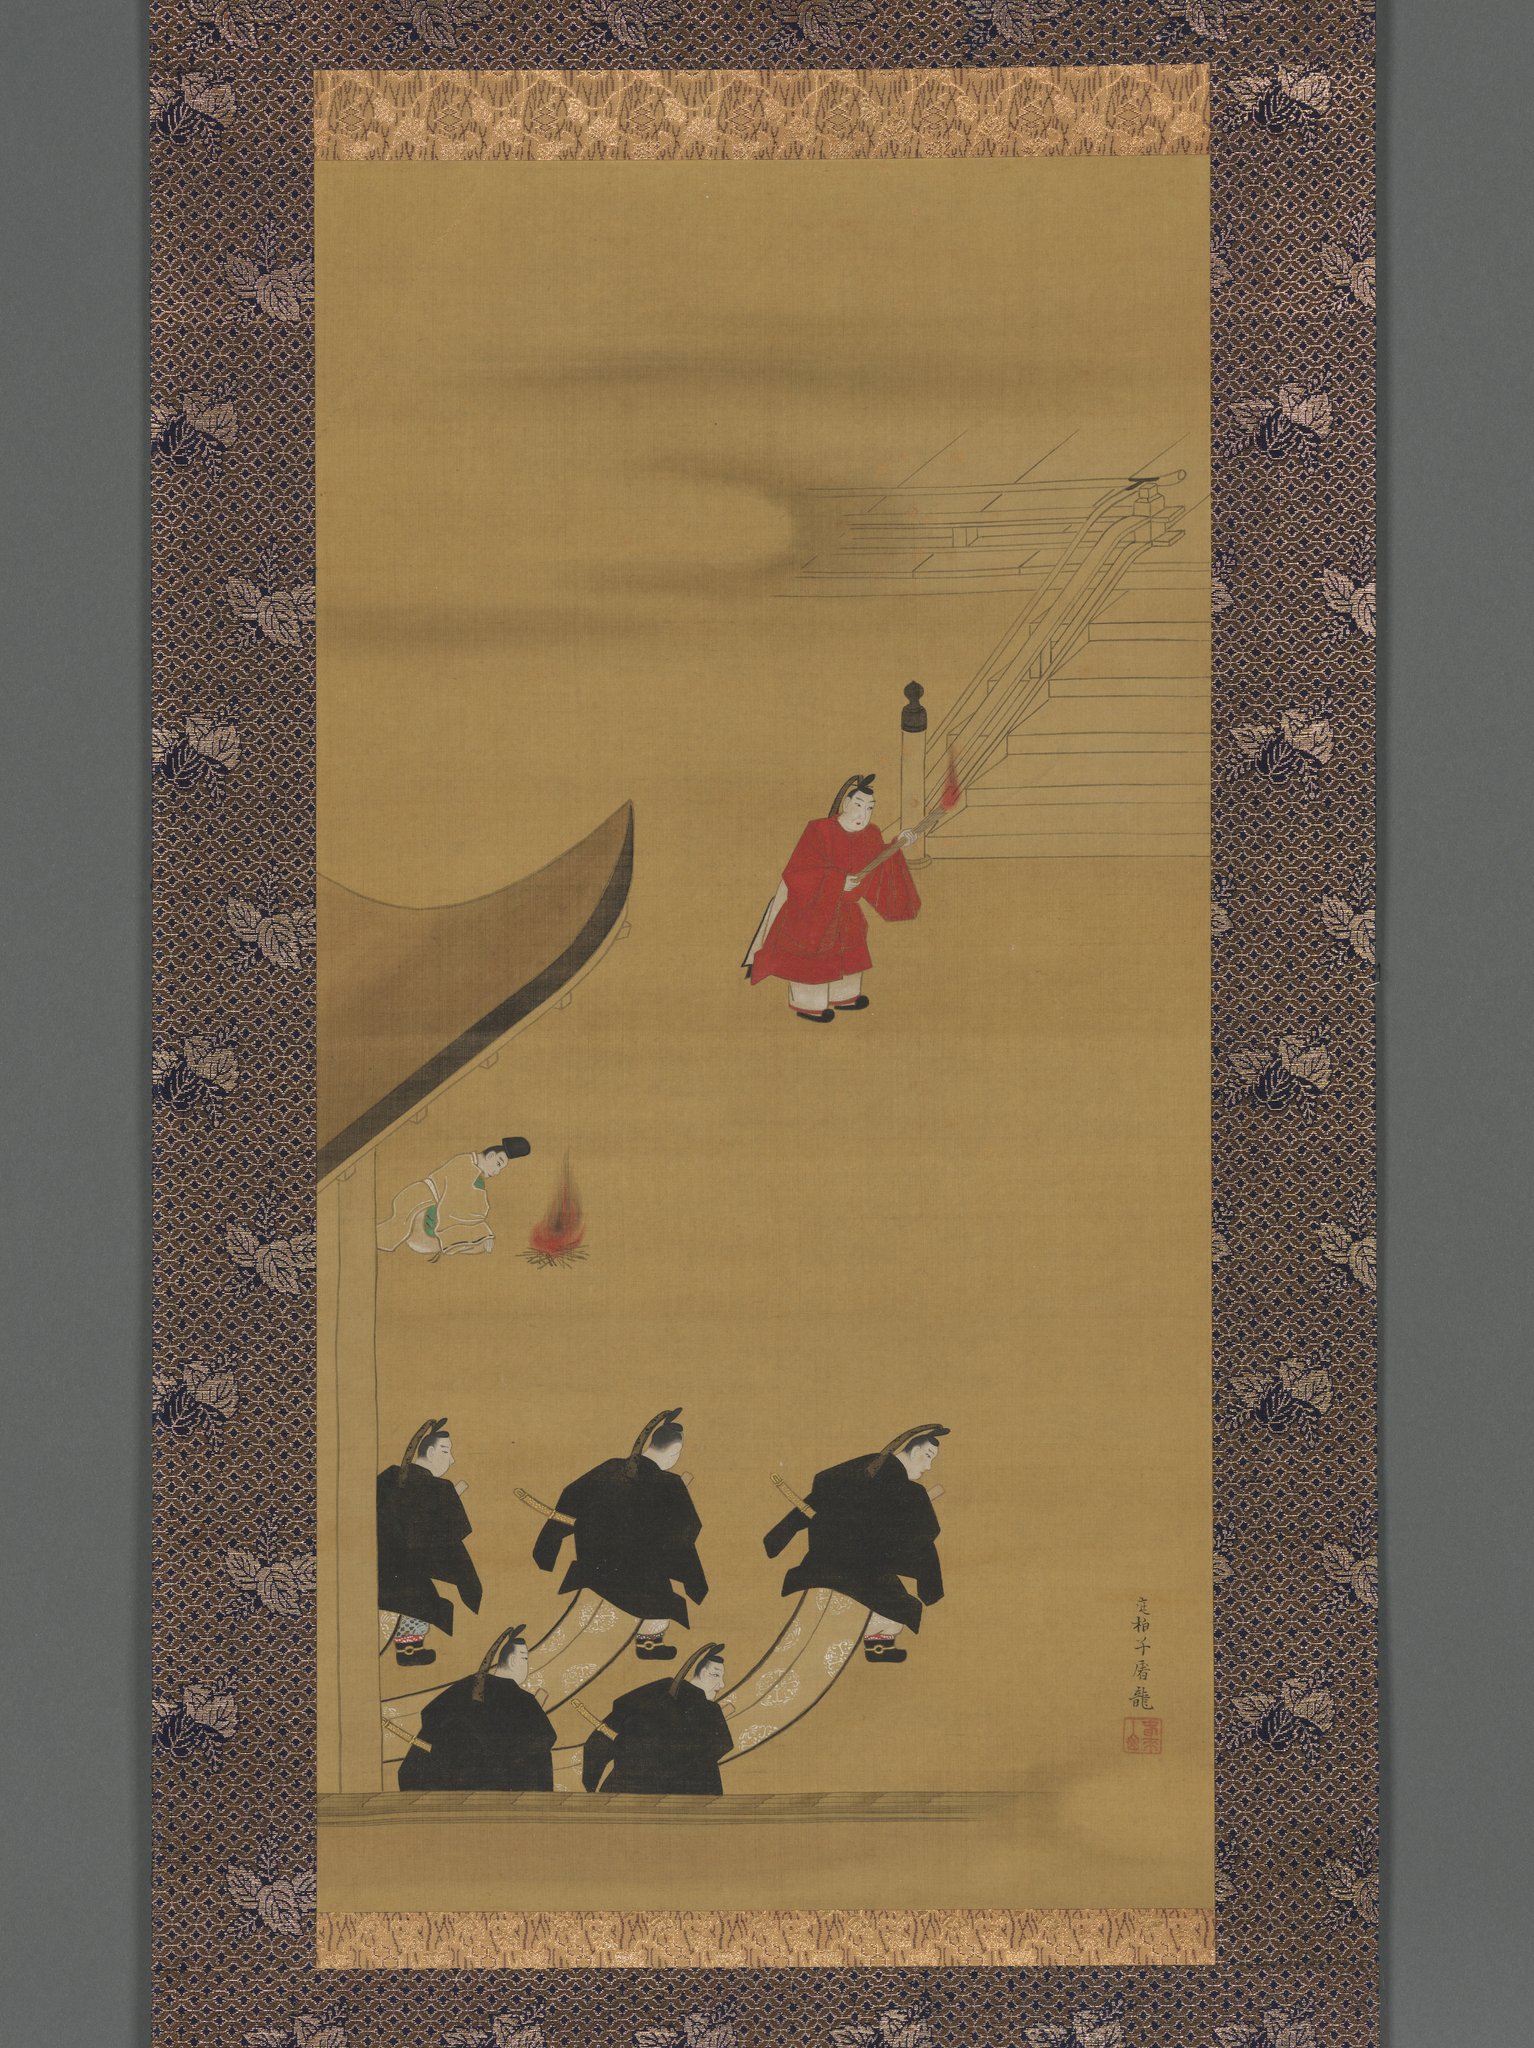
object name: hanging scroll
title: Activities of the Twelve Months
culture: japanese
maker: sakai hōitsu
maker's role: artist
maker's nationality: japanese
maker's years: 1761-1828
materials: ink, silk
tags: men